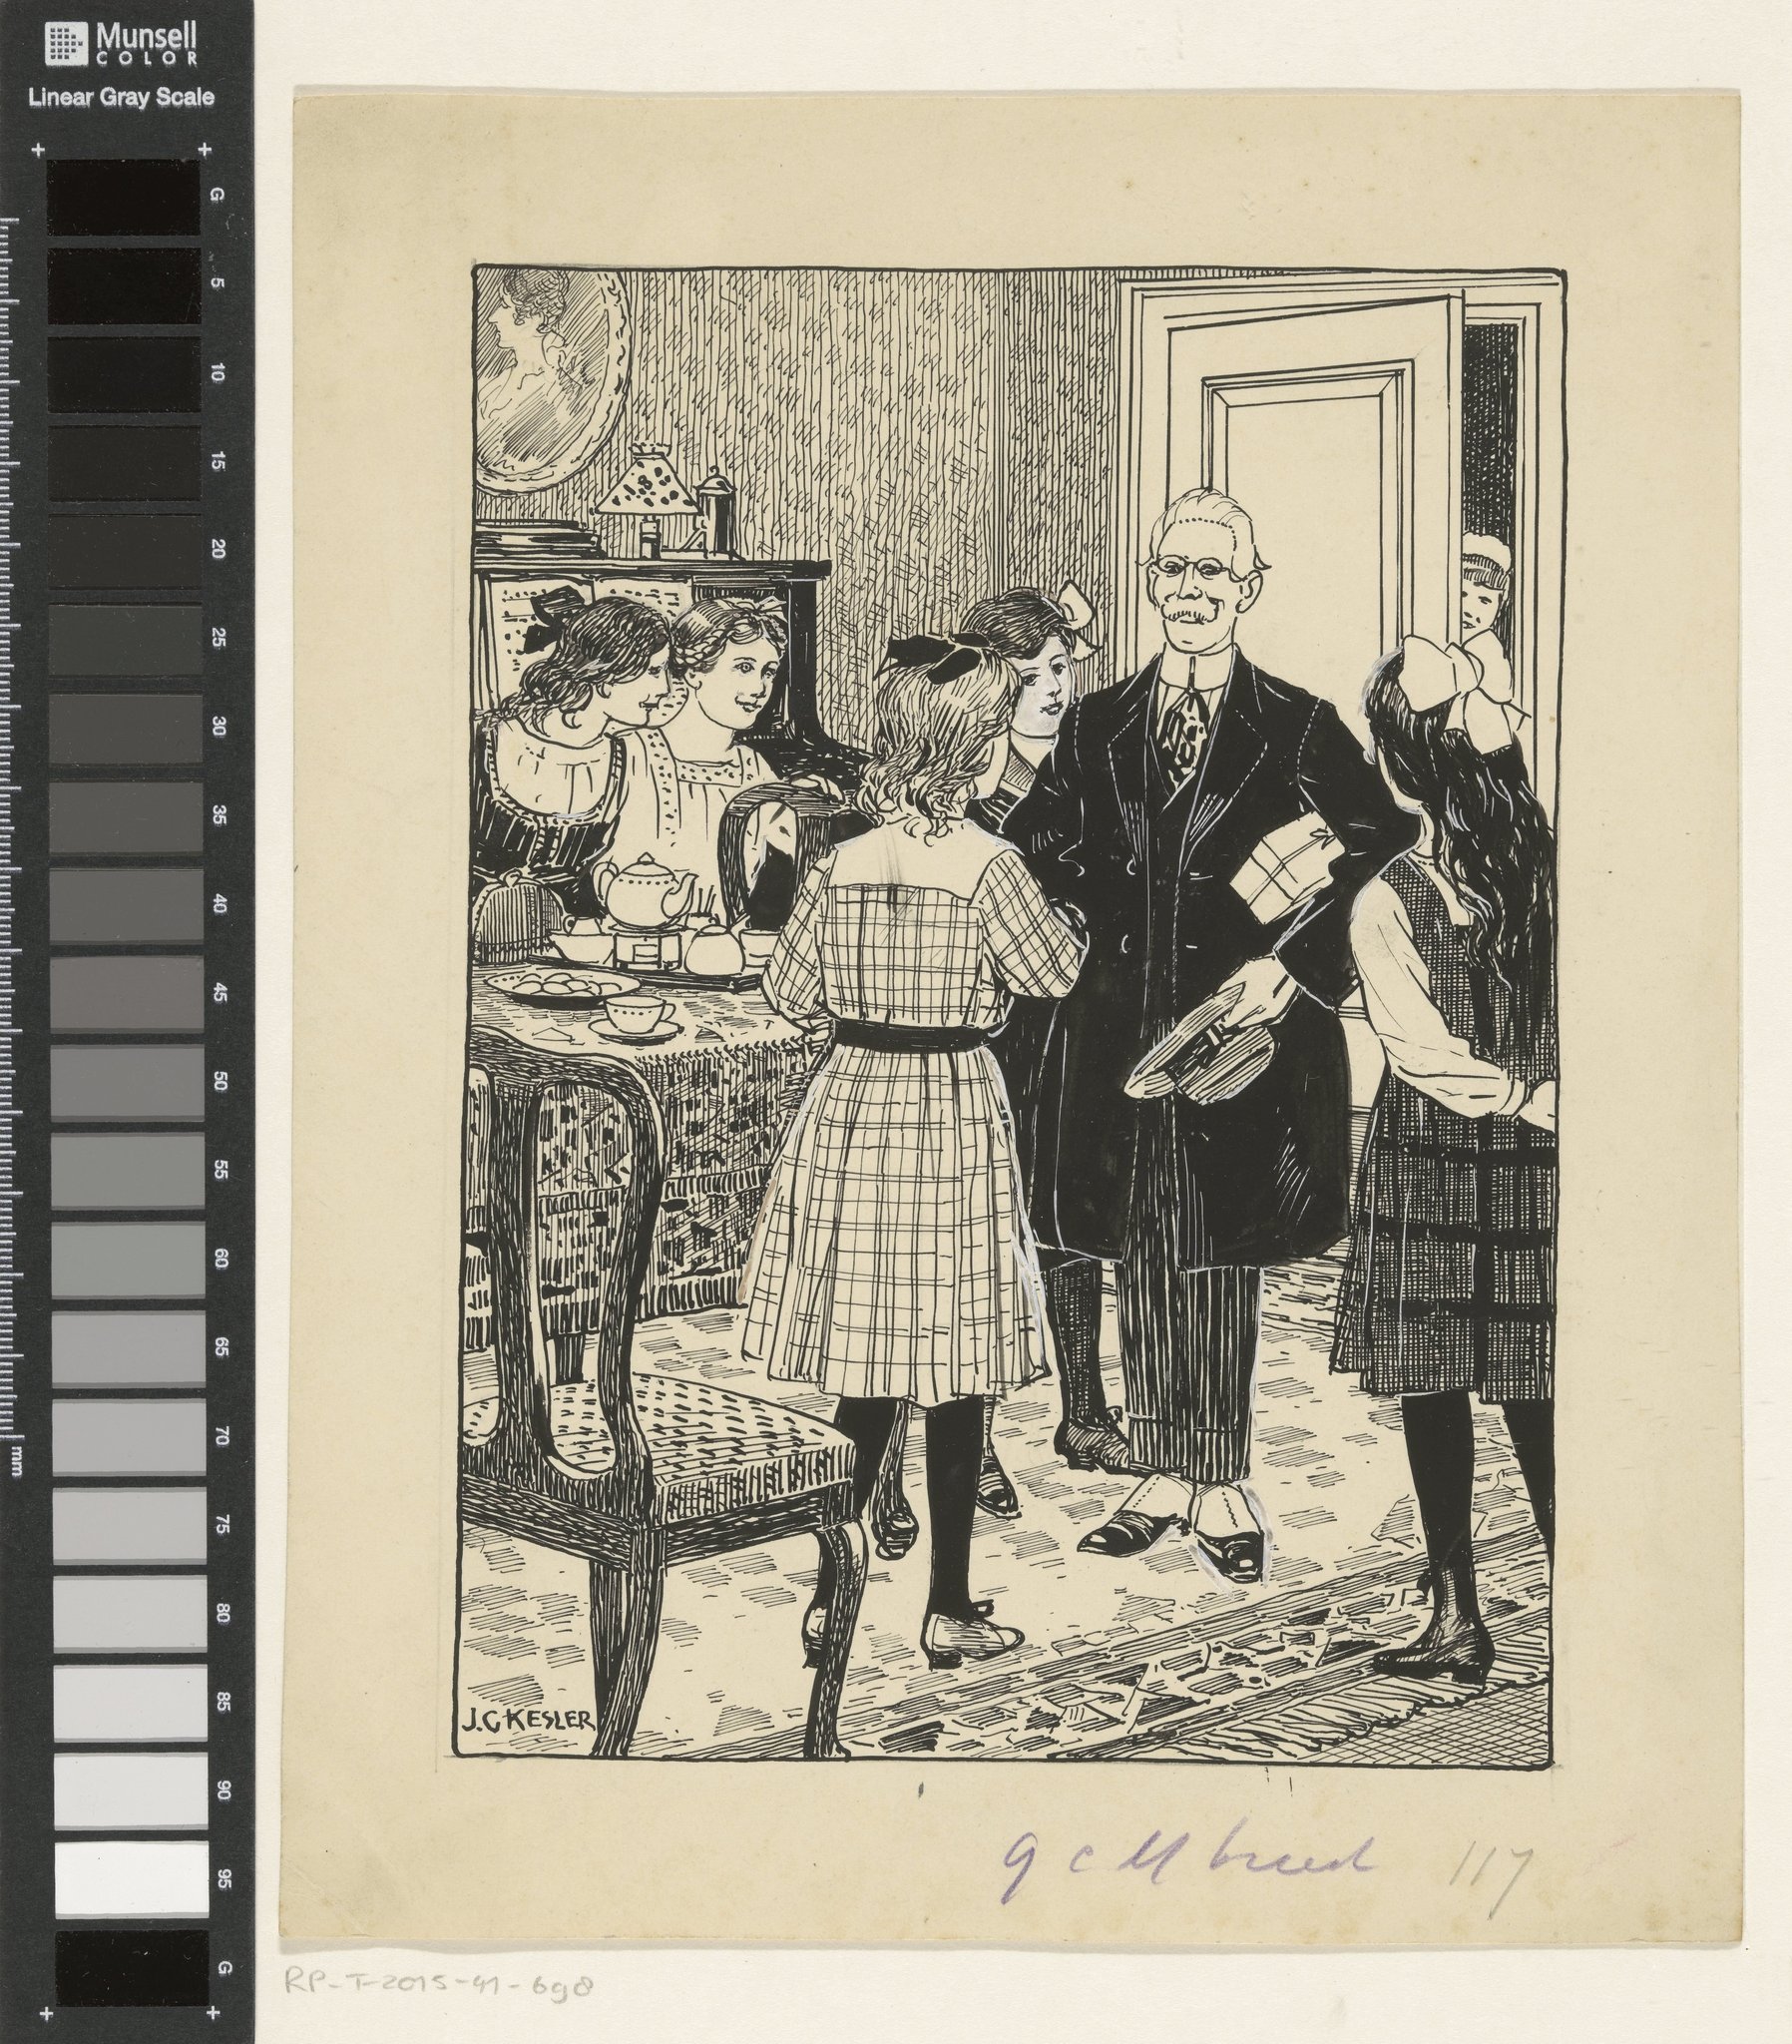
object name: drawing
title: Interieur met vijf meisjes en een oudere man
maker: johannes godefridus kesler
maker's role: draughtsman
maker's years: 1873-1938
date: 1883-1938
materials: paint, ink, paper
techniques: brush, pen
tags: interior of the house, tea- and coffee-service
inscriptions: collector's mark: Lugt 2228, :, signature: ‘J.G KESLER’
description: In een interieur staan en zitten vijf meisjes rond een tafel waarop een theeservies staat uitgestald. Een oudere man komt de kamer binnen. Hij heeft een hoed in de hand en draagt een pakje onder zijn arm.